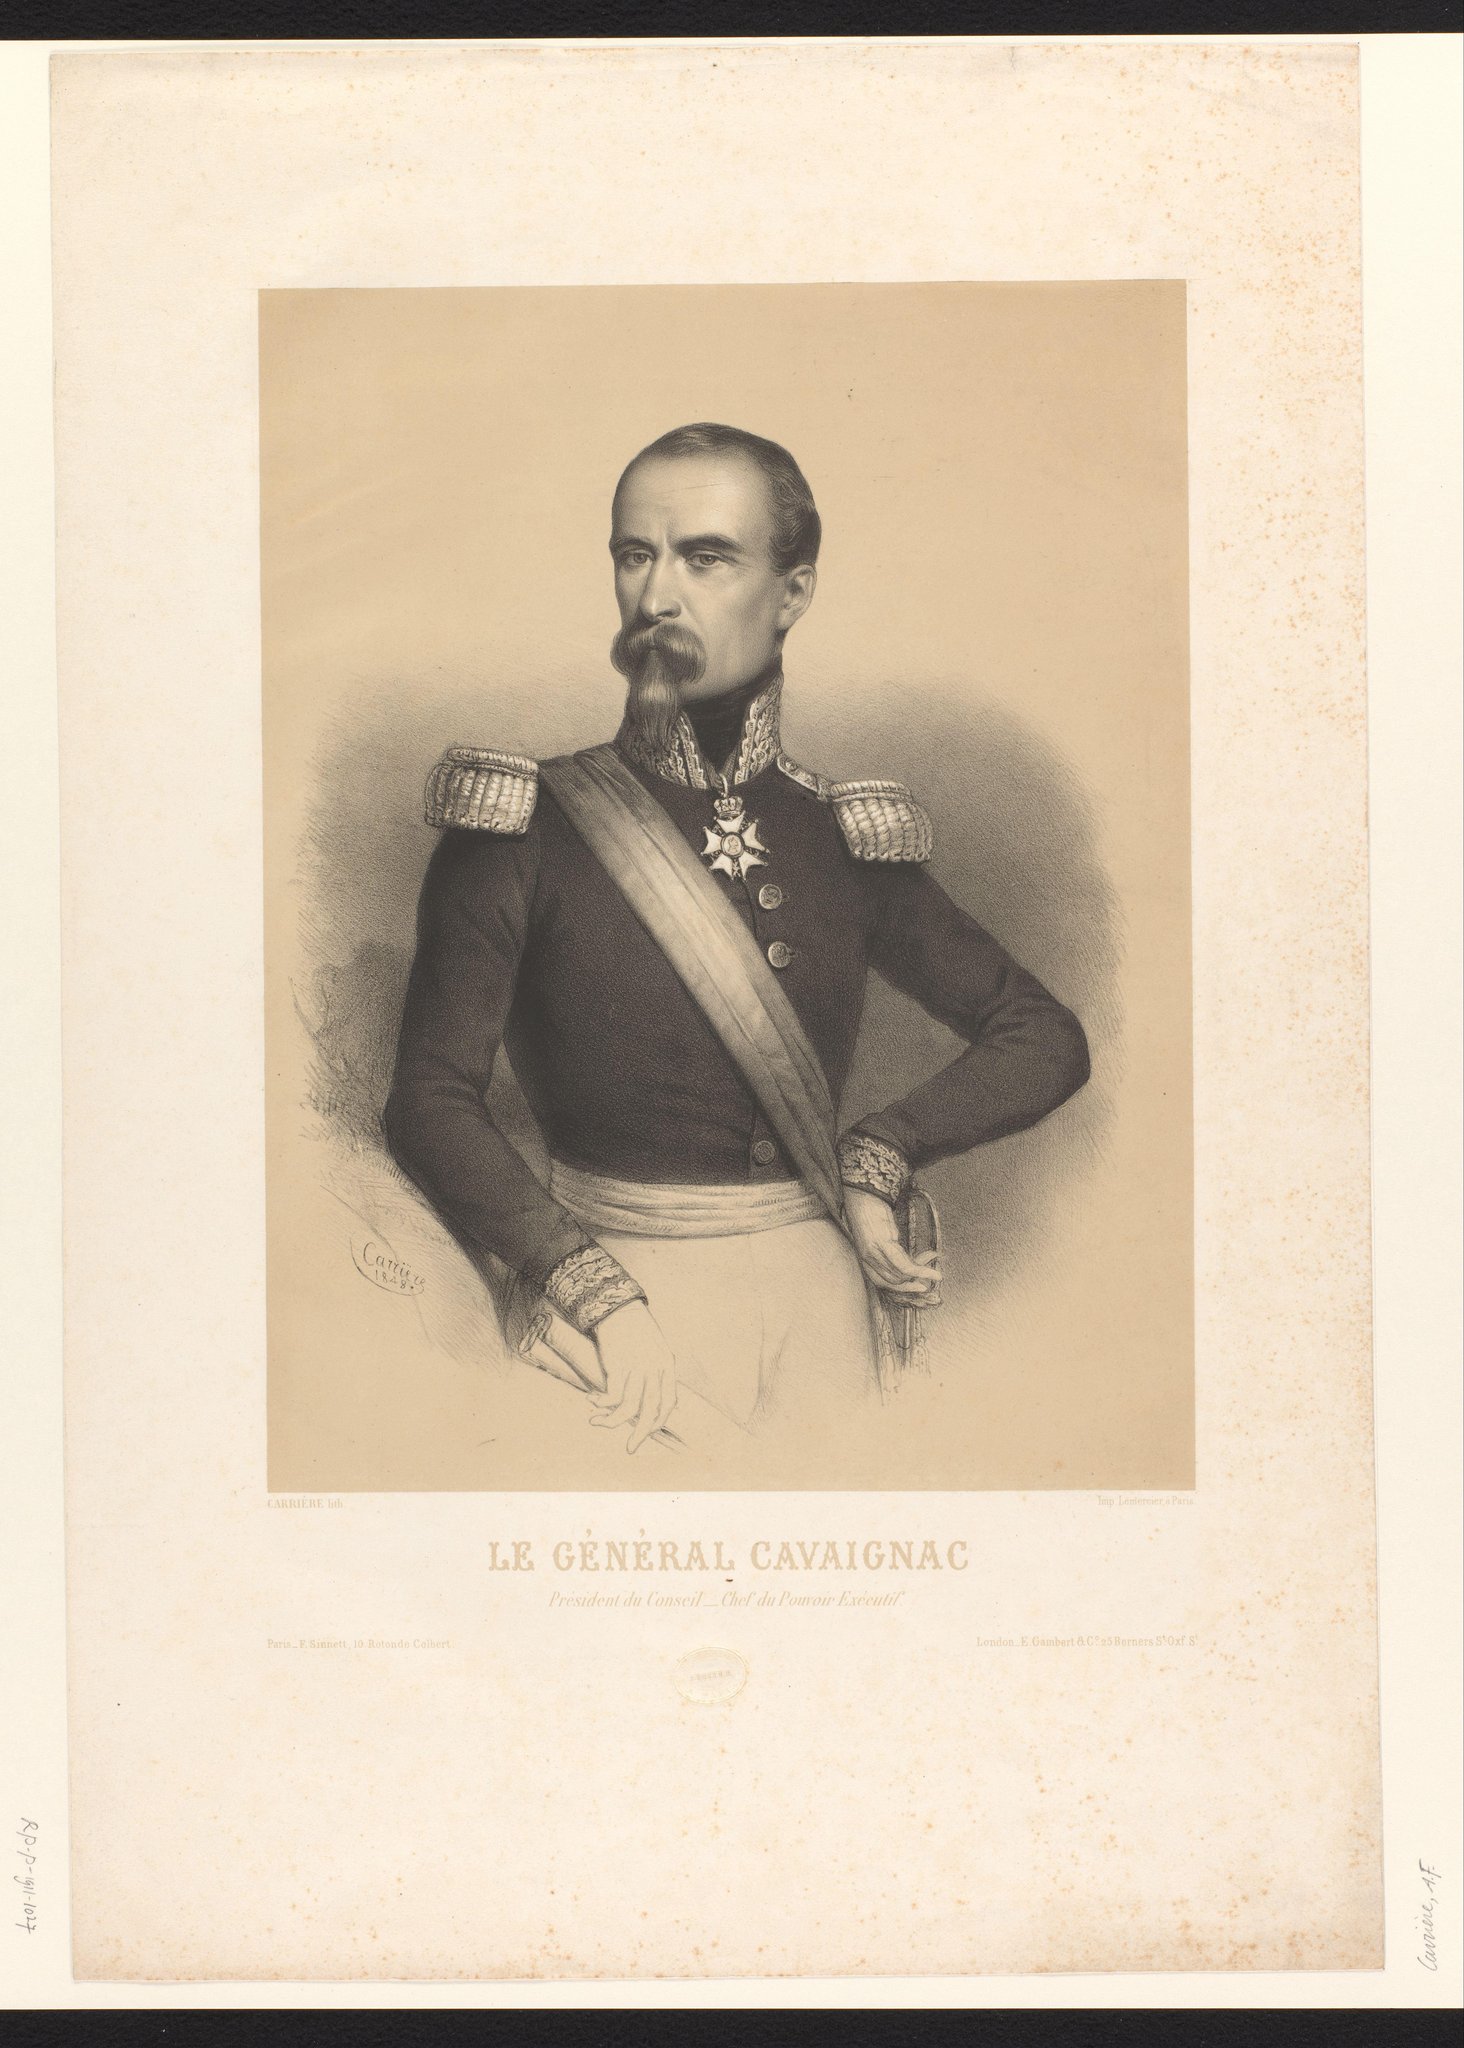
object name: print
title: Le Général Cavaignac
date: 1848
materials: paper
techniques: tone lithography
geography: paris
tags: historical persons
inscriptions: collector's mark: Lugt 2228a, check stamp: ‘F. Sinnett, éditeur à Paris’